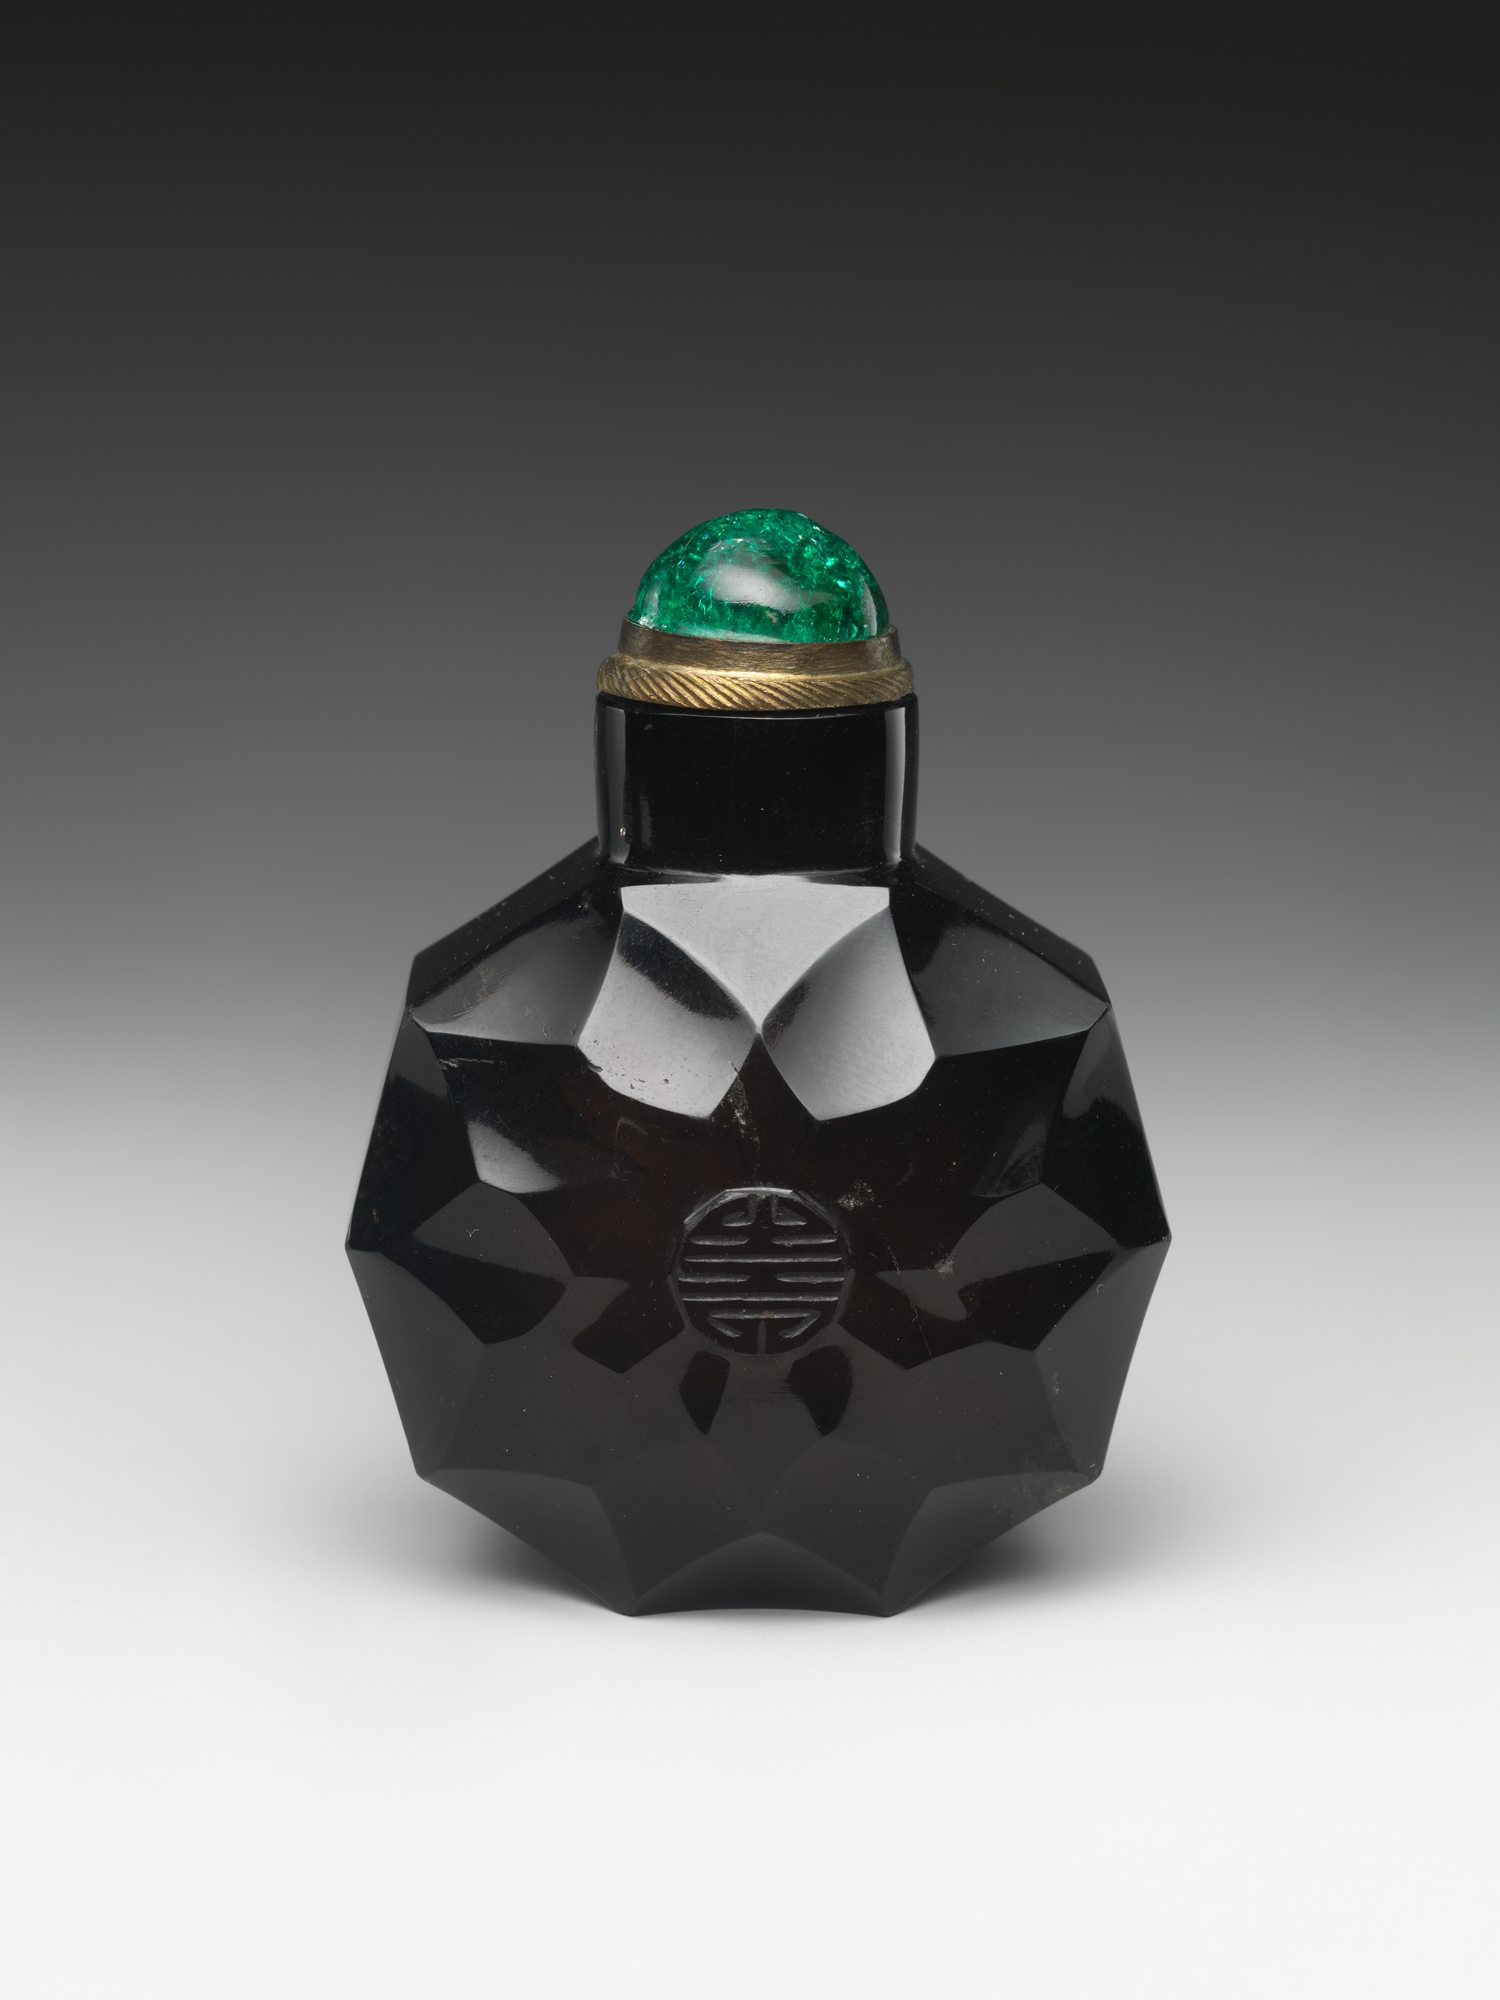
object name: snuff bottle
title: Snuff Bottle with the Chinese Character of Longevity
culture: chinese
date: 1767-1800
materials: glass, quartz